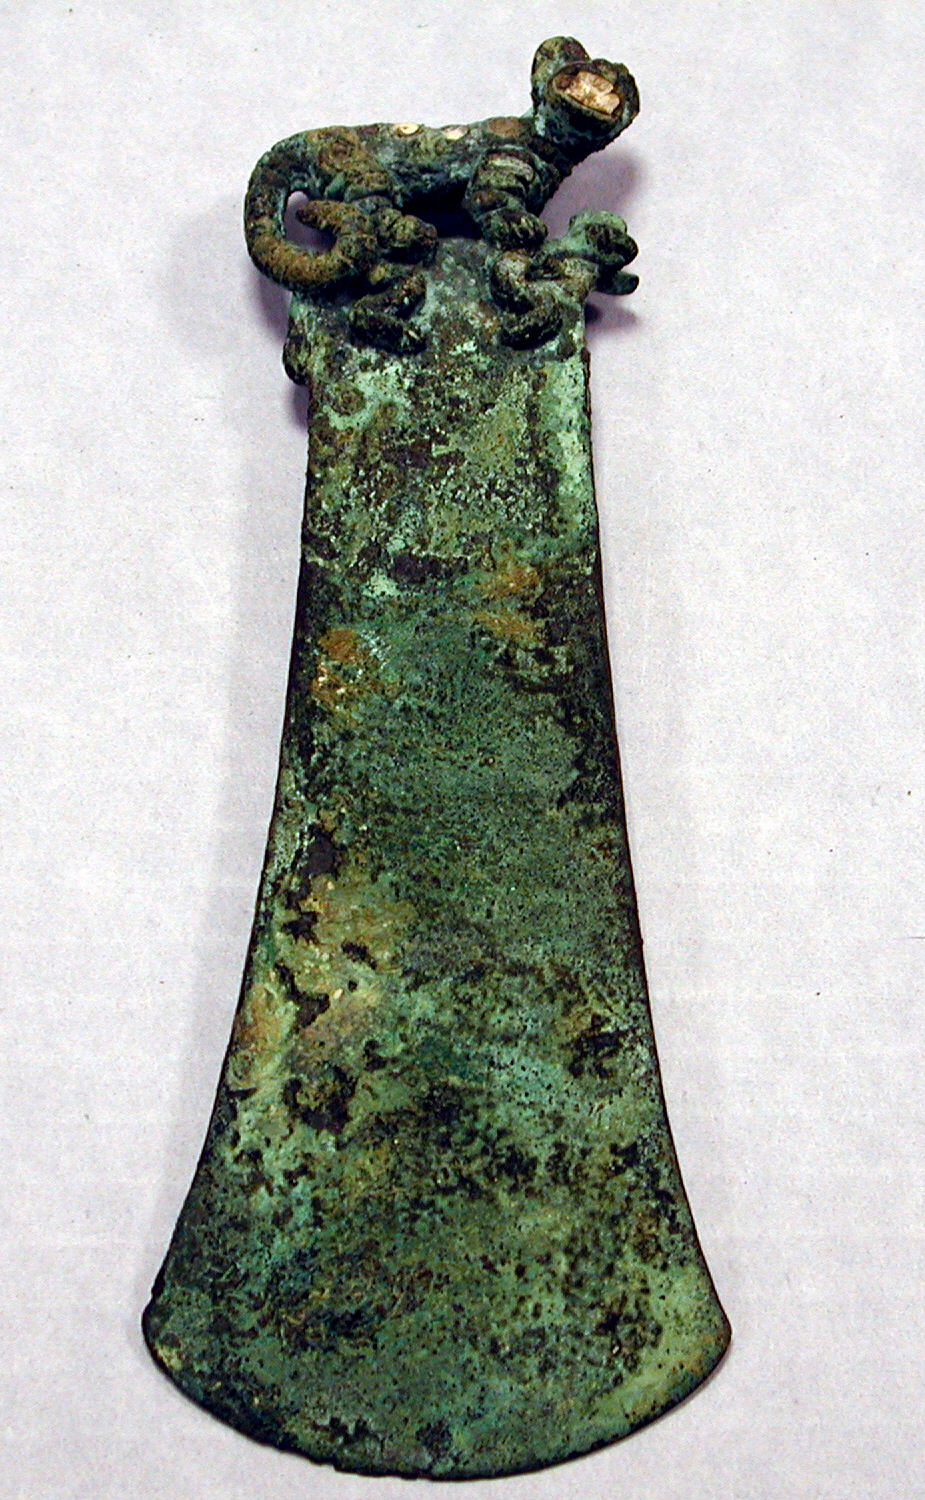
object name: knife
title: Tumi with Feline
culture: moche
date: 101-700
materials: copper, shell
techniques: casting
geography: peru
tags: animals